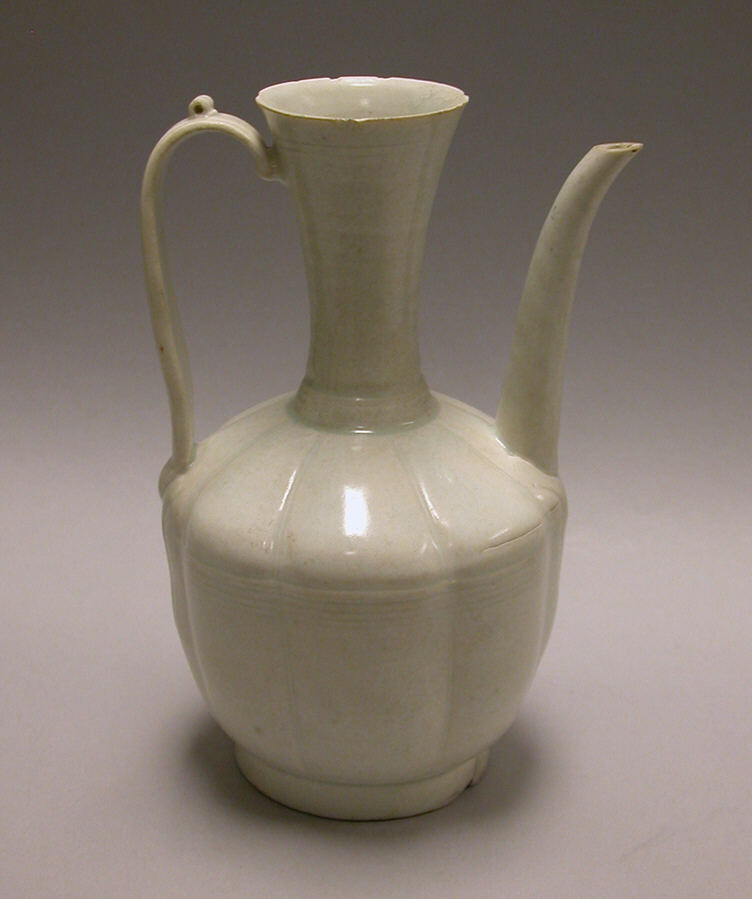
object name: ewer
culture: chinese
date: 1001-1100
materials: glaze, porcelain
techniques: incising